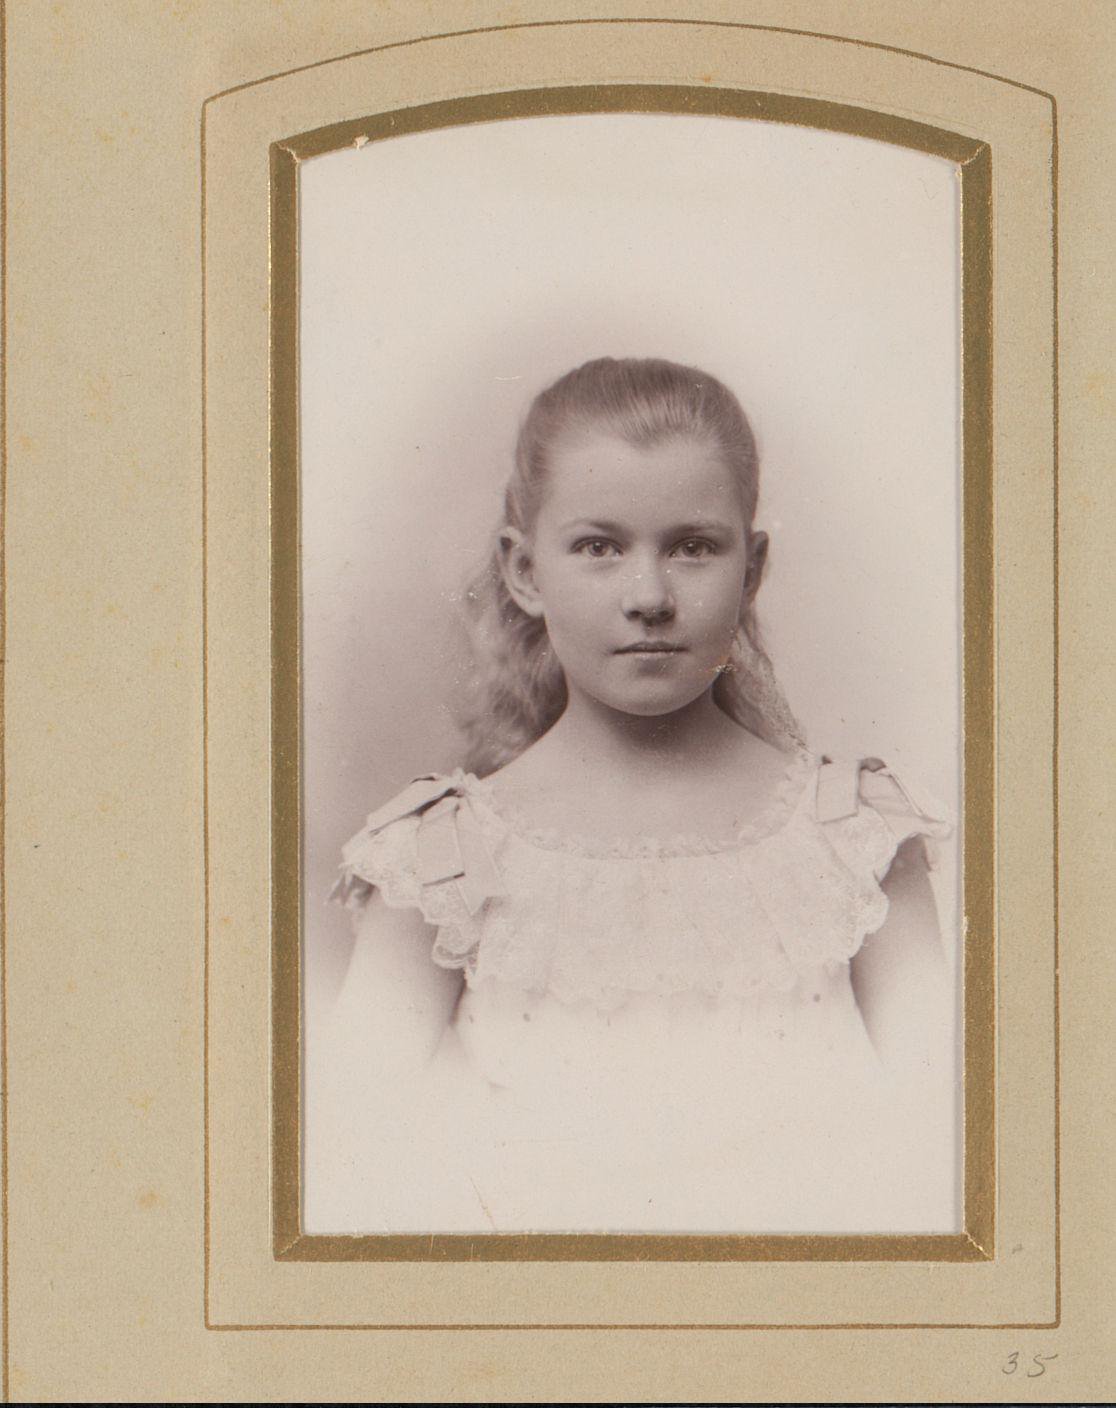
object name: photograph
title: Studioportret van An Kessler op jeugdige leeftijd in een wit jurkje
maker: kameke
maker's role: painter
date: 1891-1895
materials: paper, photographic support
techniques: photography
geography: amsterdam